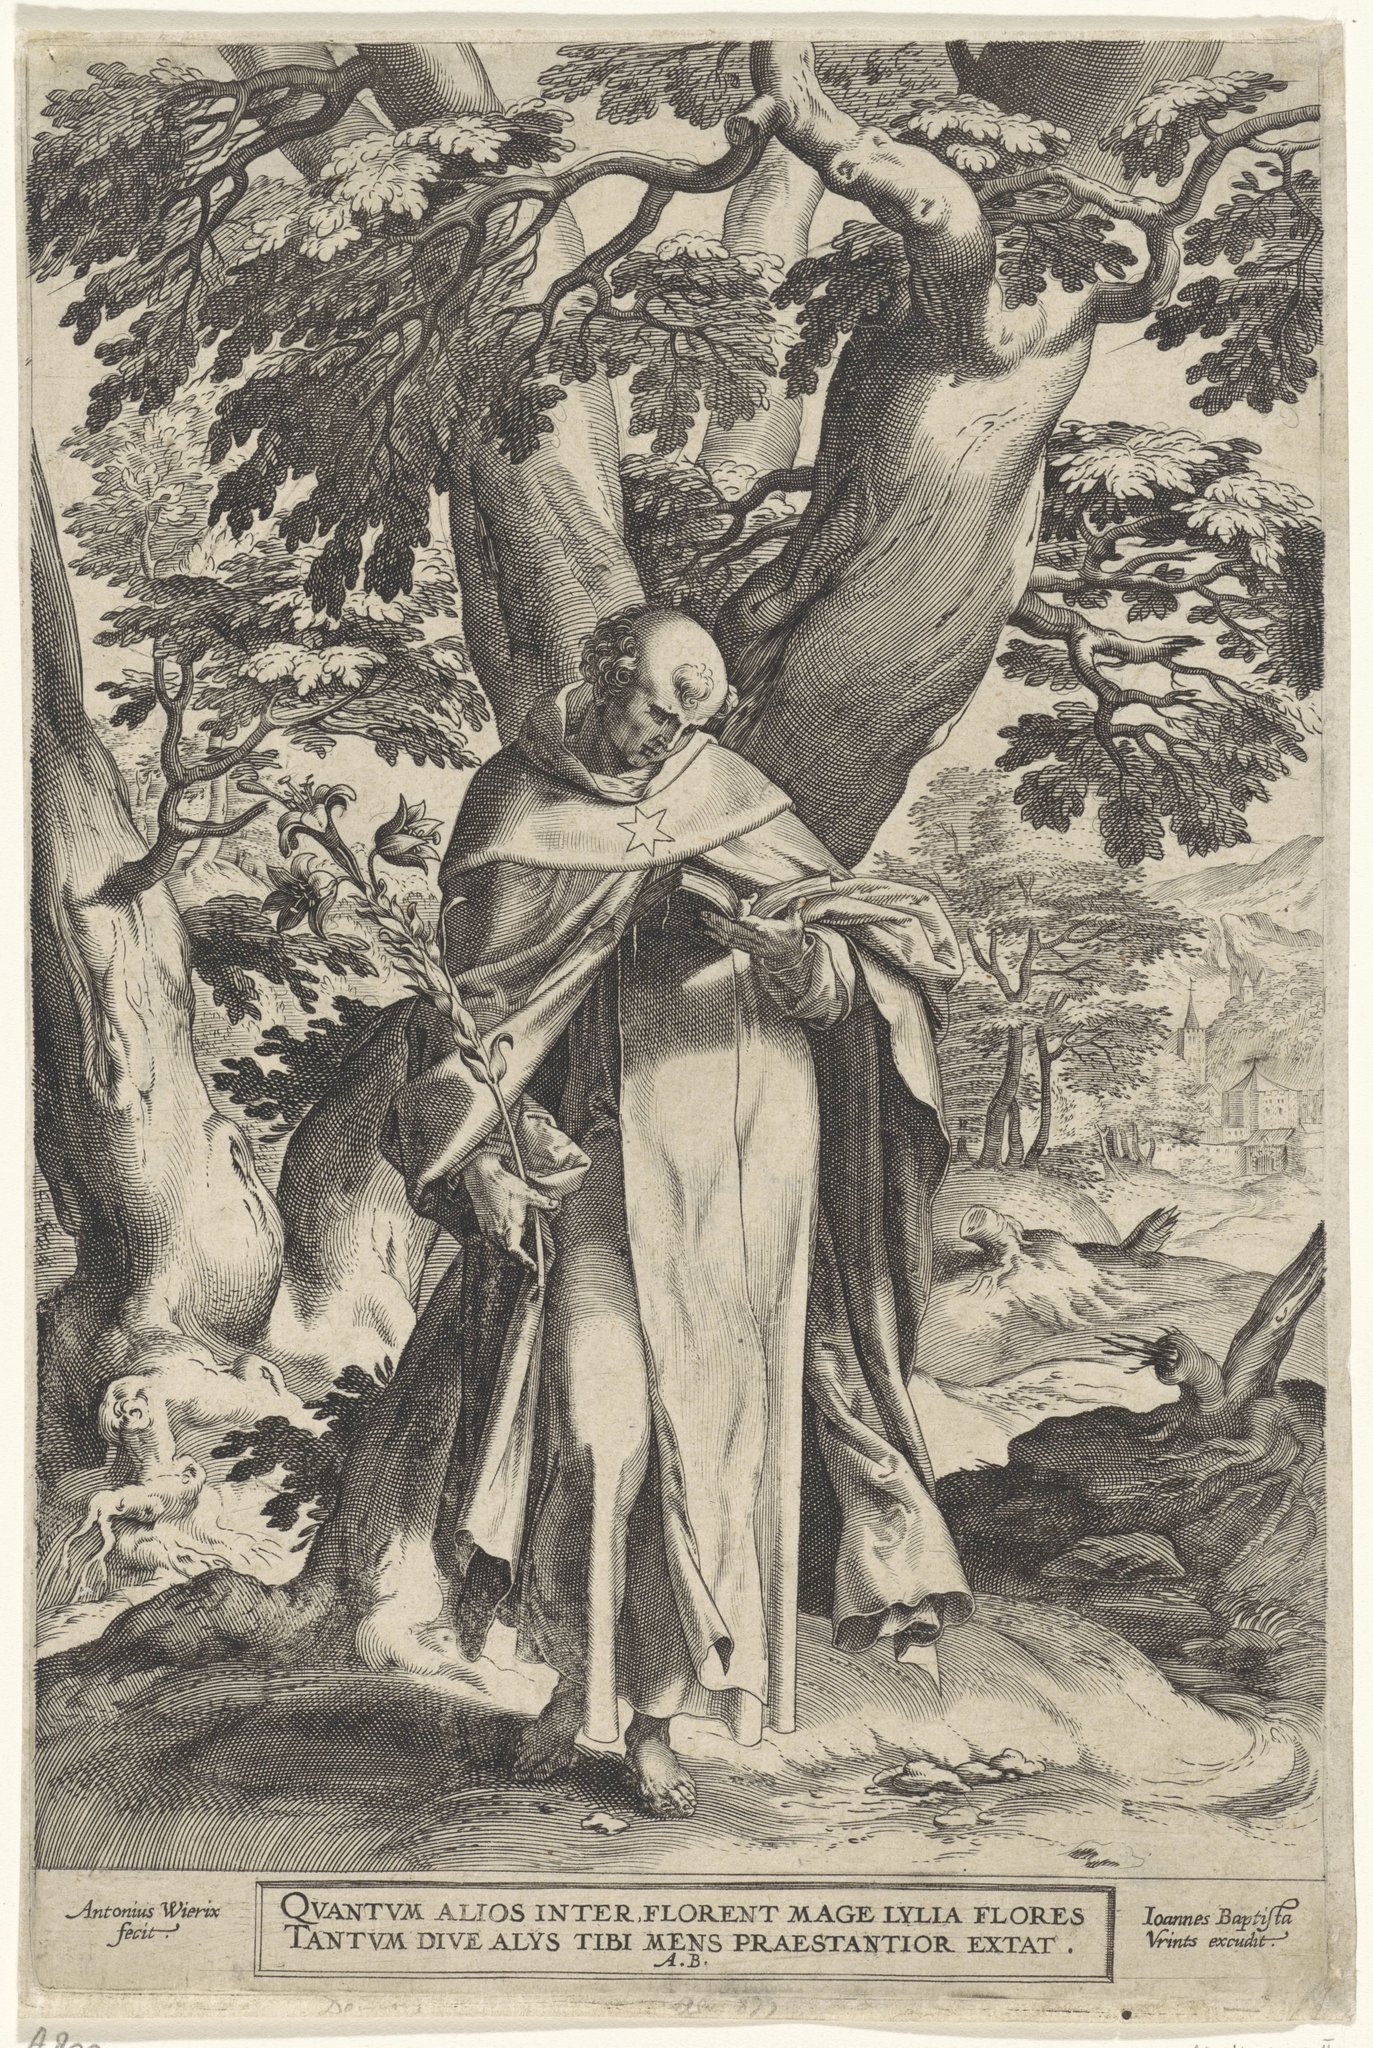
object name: print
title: Landschap met de H. Dominicus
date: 1573-1604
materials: paper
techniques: engraving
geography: antwerp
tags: dominic(us) guzman of calerueja, founder of the order of preachers (or dominican (black) friars; possible attributes: book, dog with flaming torch, lily, loaf of bread, rosary, star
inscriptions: collector's mark: Lugt 1337, collector's mark: Lugt 2228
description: De heilige Dominicus in het bos, in zijn ene hand houdt hij een lelie, in zijn andere hand een opengeslagen boek. Op zijn mantel een ster, symbool voor het bovennatuurlijke licht dat hij uitstraalde. In het kader in de marge een tweeregelig onderschrift in het Latijn.